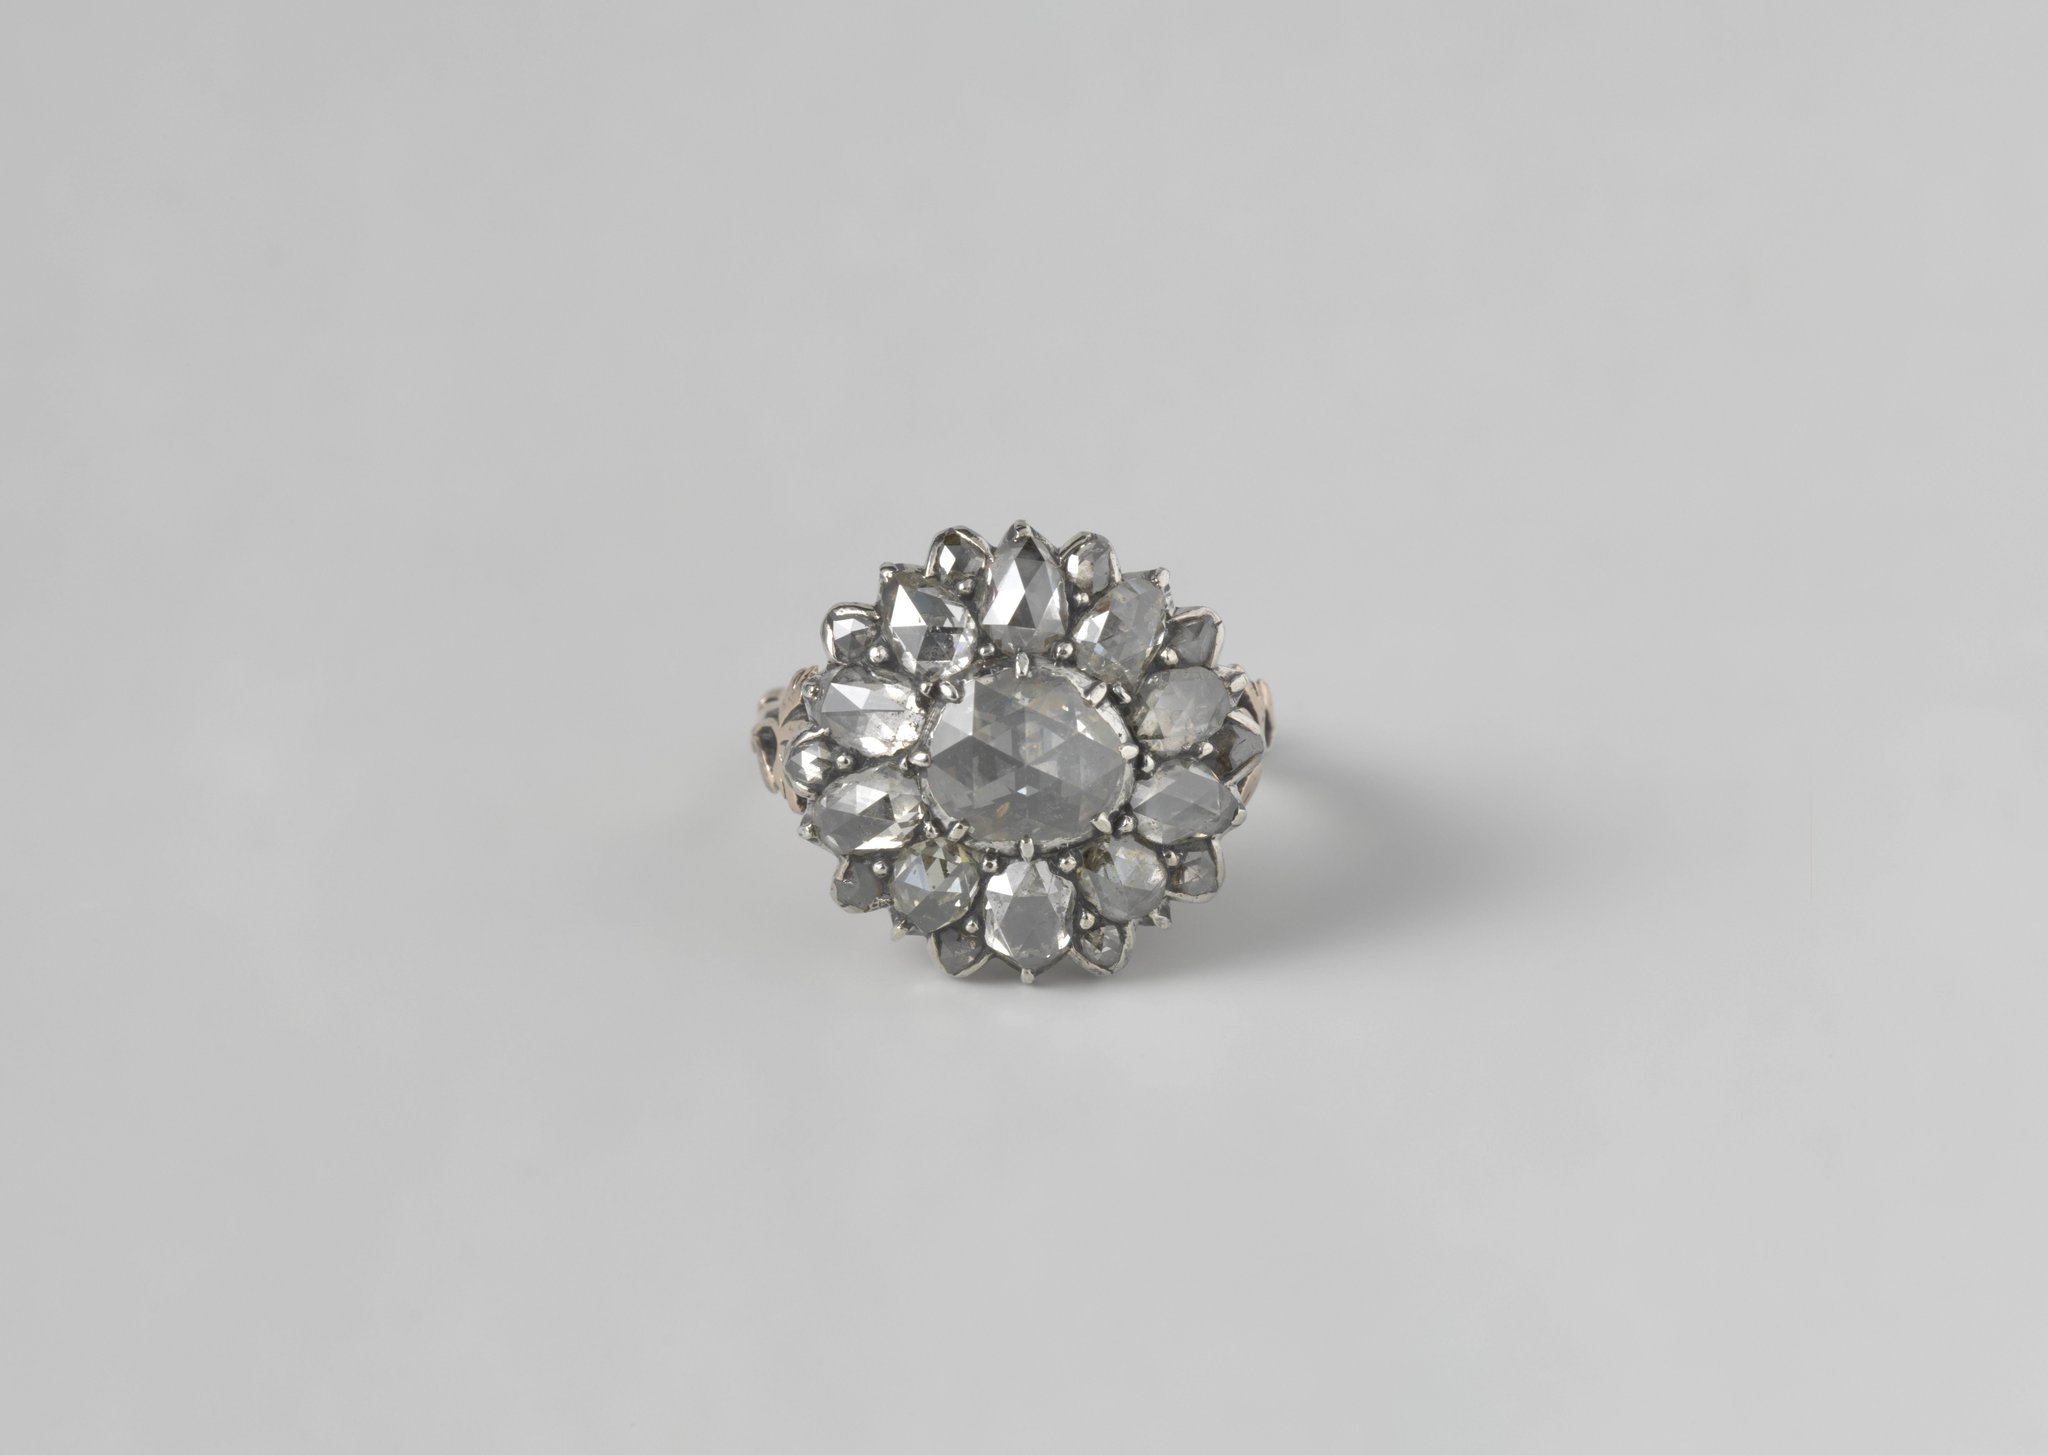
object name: ring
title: Entouragering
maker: Anonymous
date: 1750-1800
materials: diamond, gold, silver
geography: great britain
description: Ring van goud, zilver en diamanten. De bovenkant van de ring is bezet met één grote diamant waaromheen tien kleinere diamanten (roosslijpsel), en tien nog kleinere diamanten. De band bestaat uit in elkaar gedraaide bloemstengels die in bladeren uitlopen.